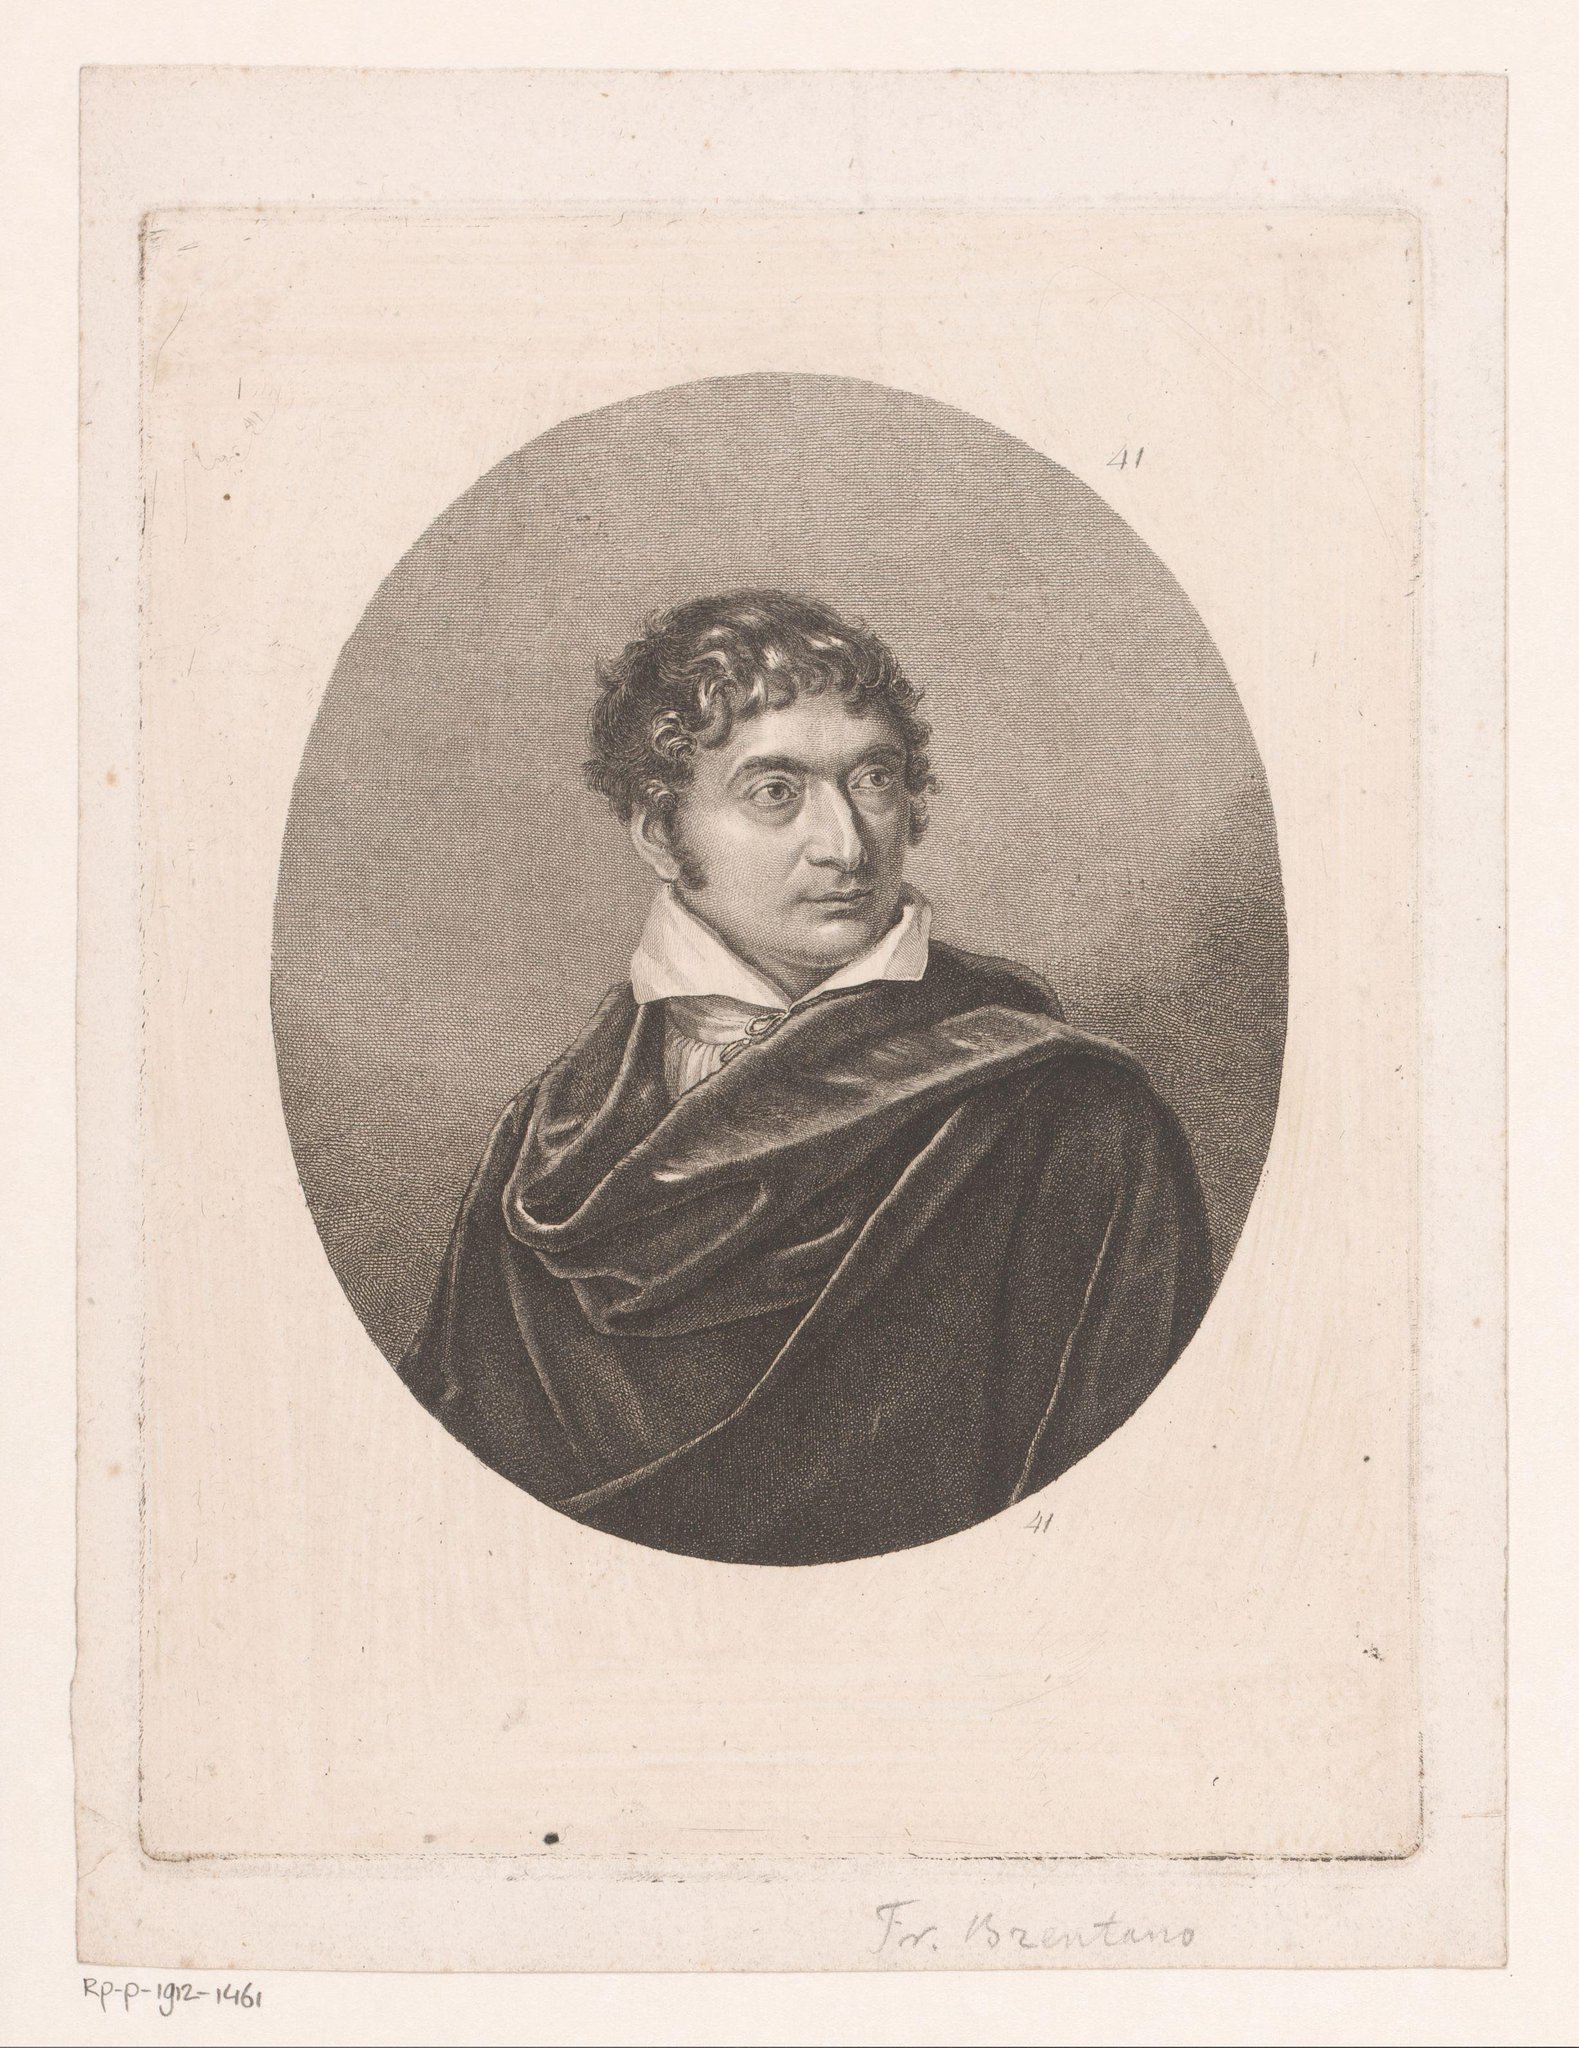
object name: print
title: Portret van Franz von Brentano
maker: ludwig emil grimm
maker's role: print maker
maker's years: 1790-1863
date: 1800-1844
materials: paper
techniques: etching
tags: historical persons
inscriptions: collector's mark: Lugt 2228